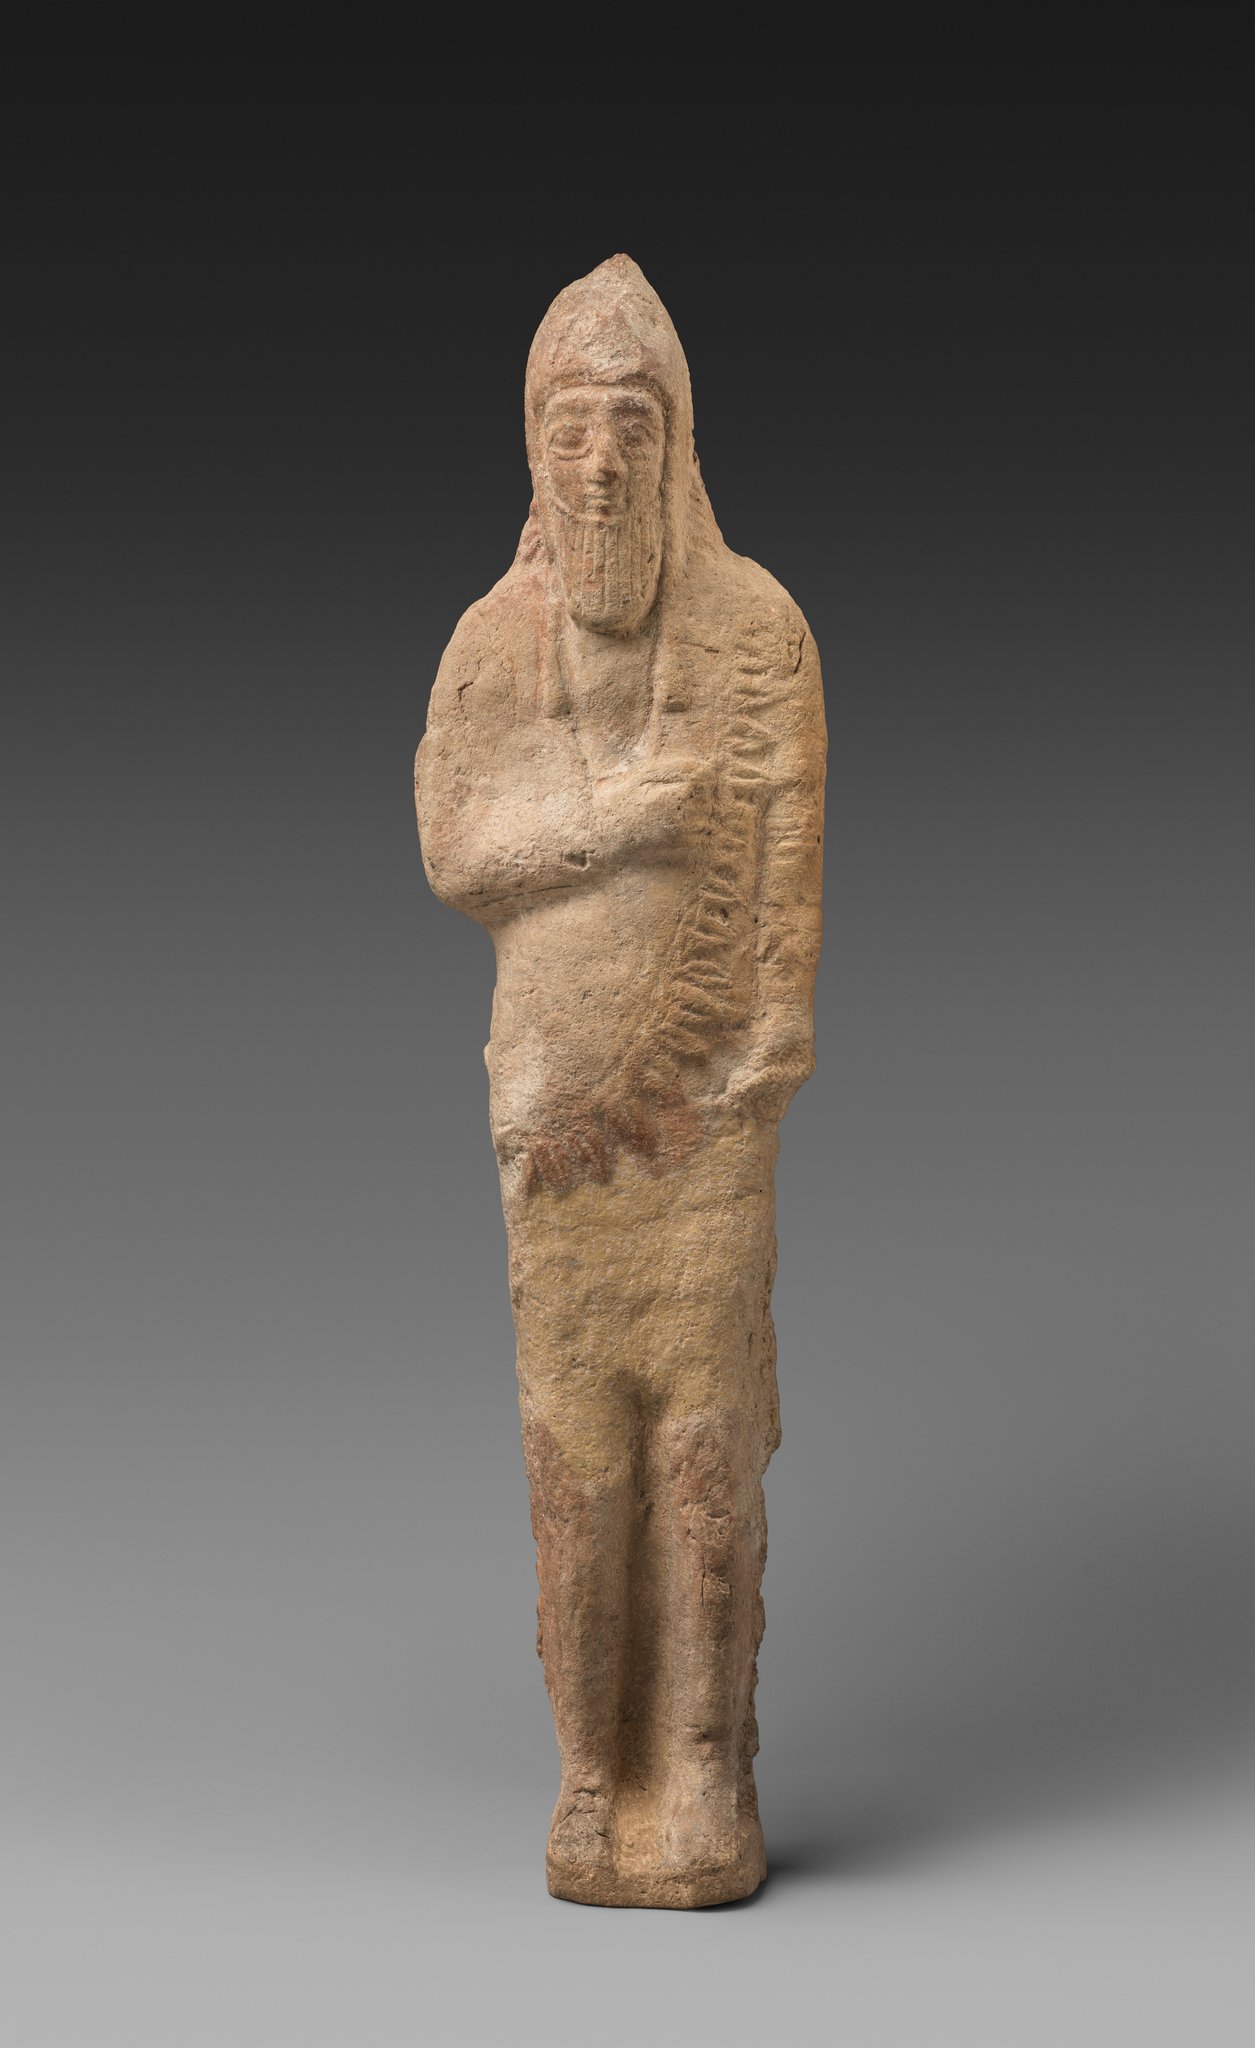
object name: statuette of a man, assyrian type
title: Standing male figurine of an "Assyrian" type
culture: cypriot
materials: terracotta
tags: men